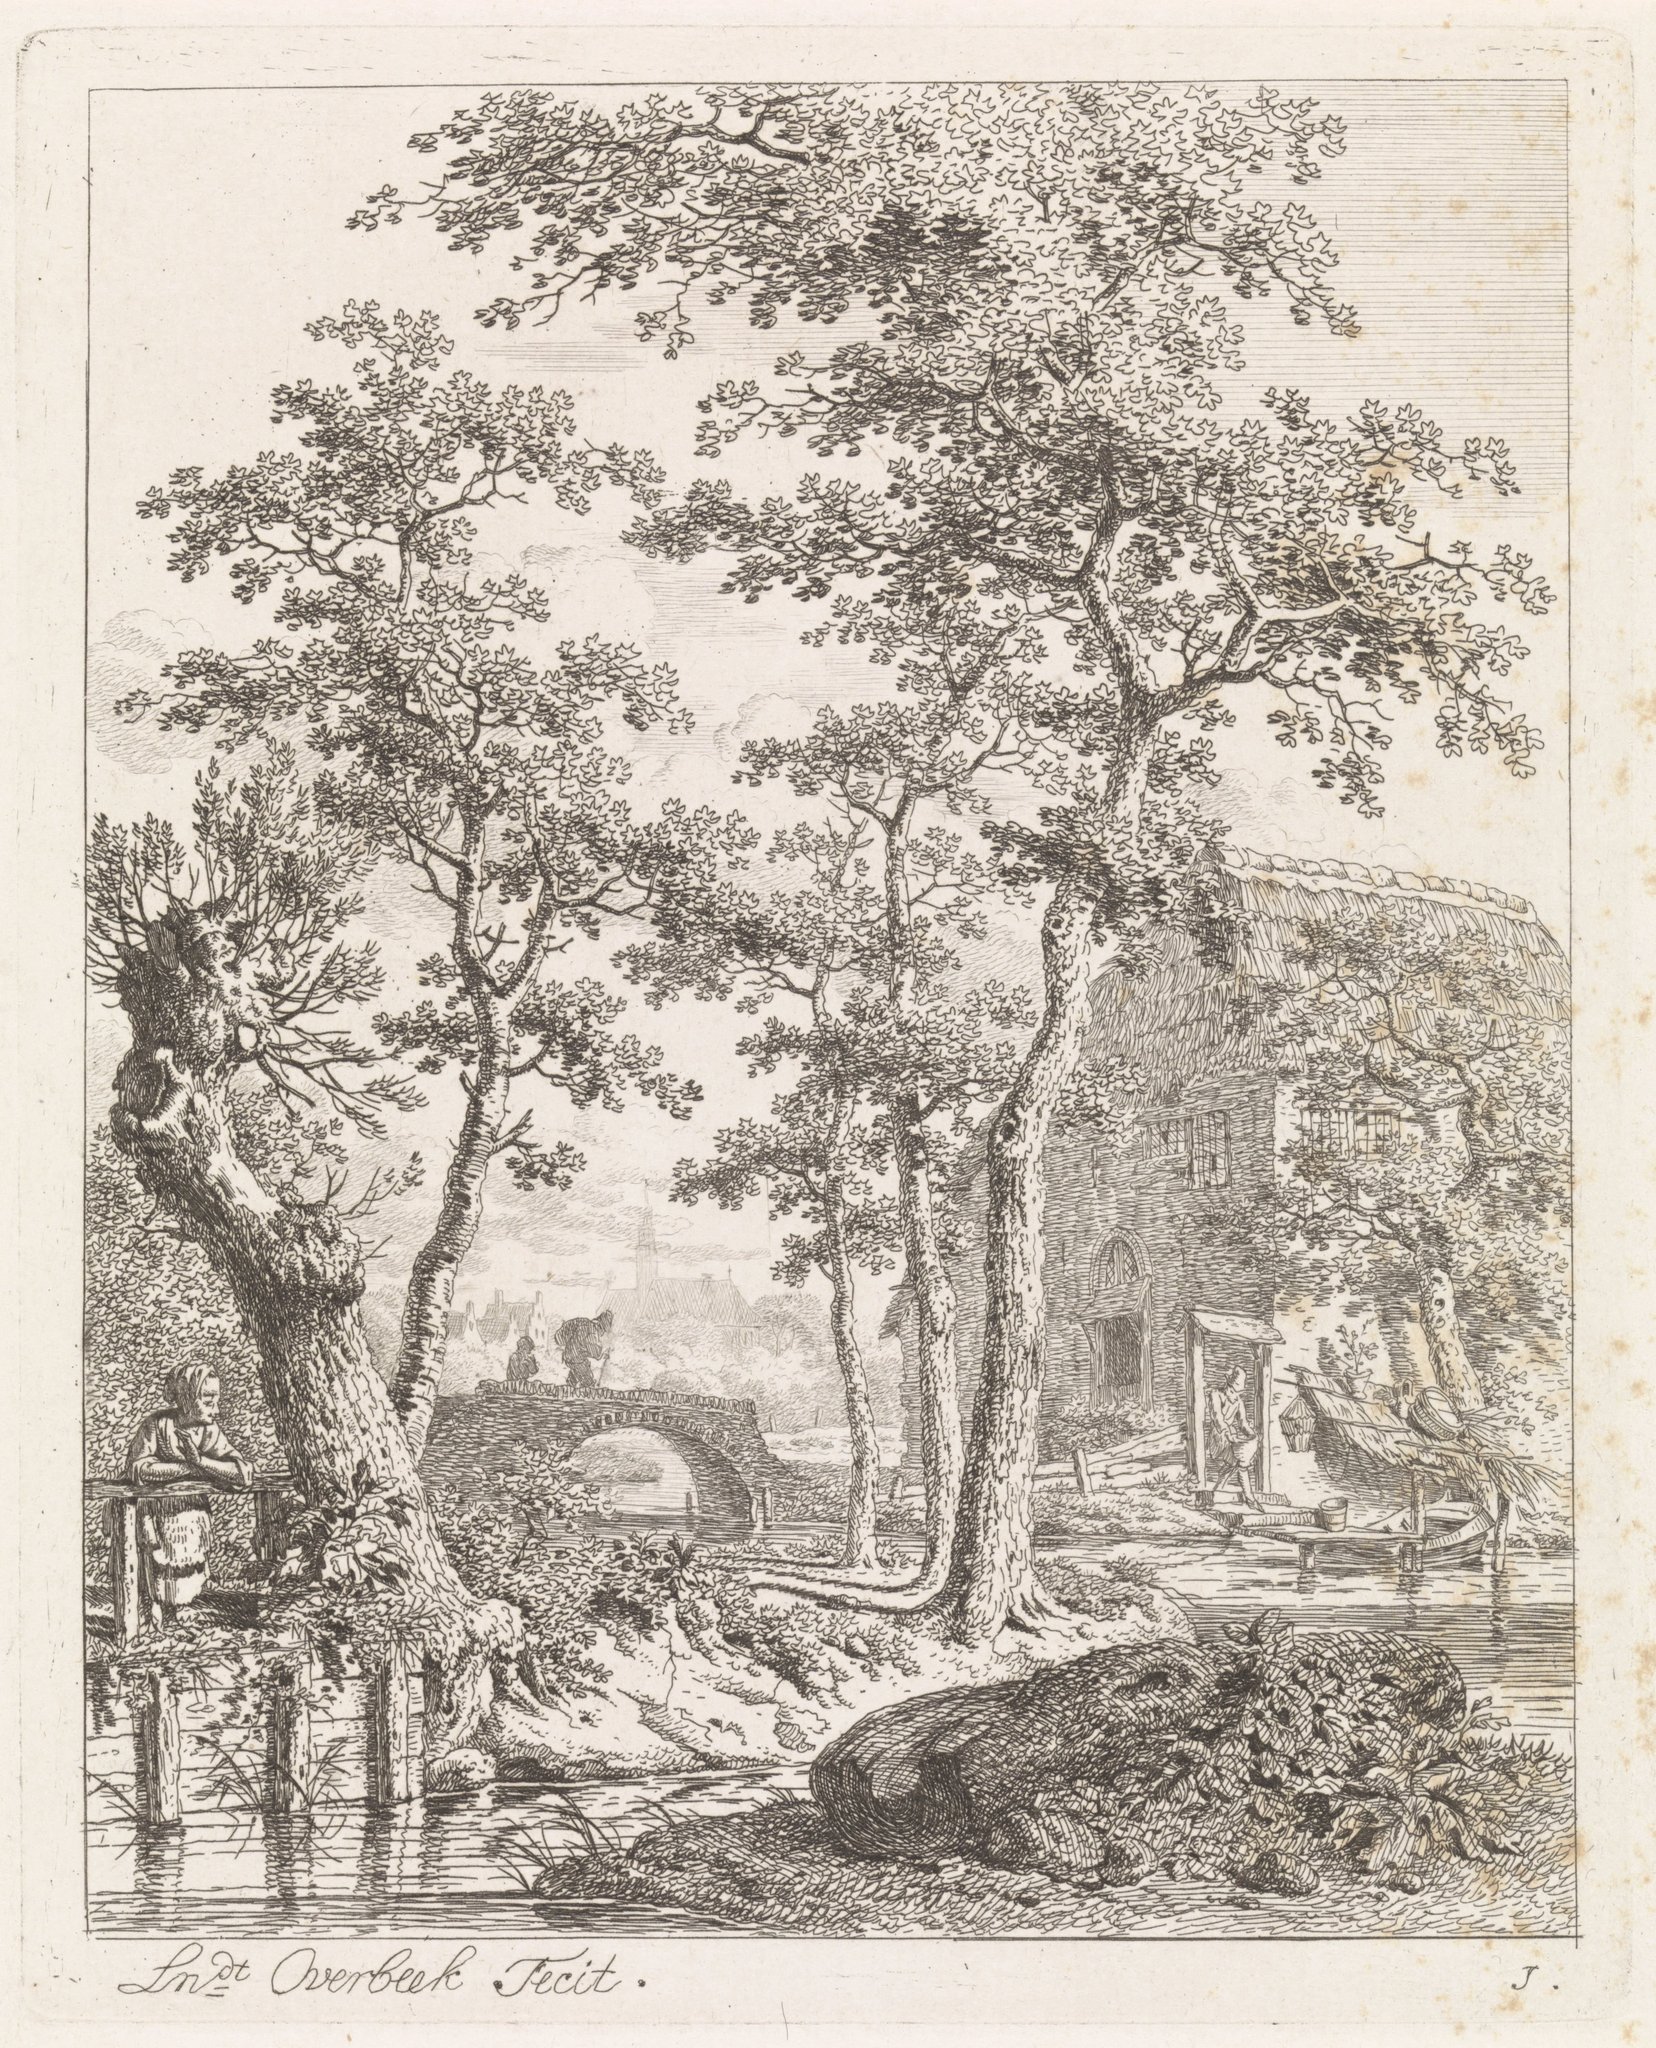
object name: print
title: Boerderij aan het water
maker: leendert overbeek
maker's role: draughtsman, painter, print maker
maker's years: 1752-1815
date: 1791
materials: paper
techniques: etching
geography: haarlem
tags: landscapes in the temperate zone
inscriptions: collector's mark: Lugt 2228